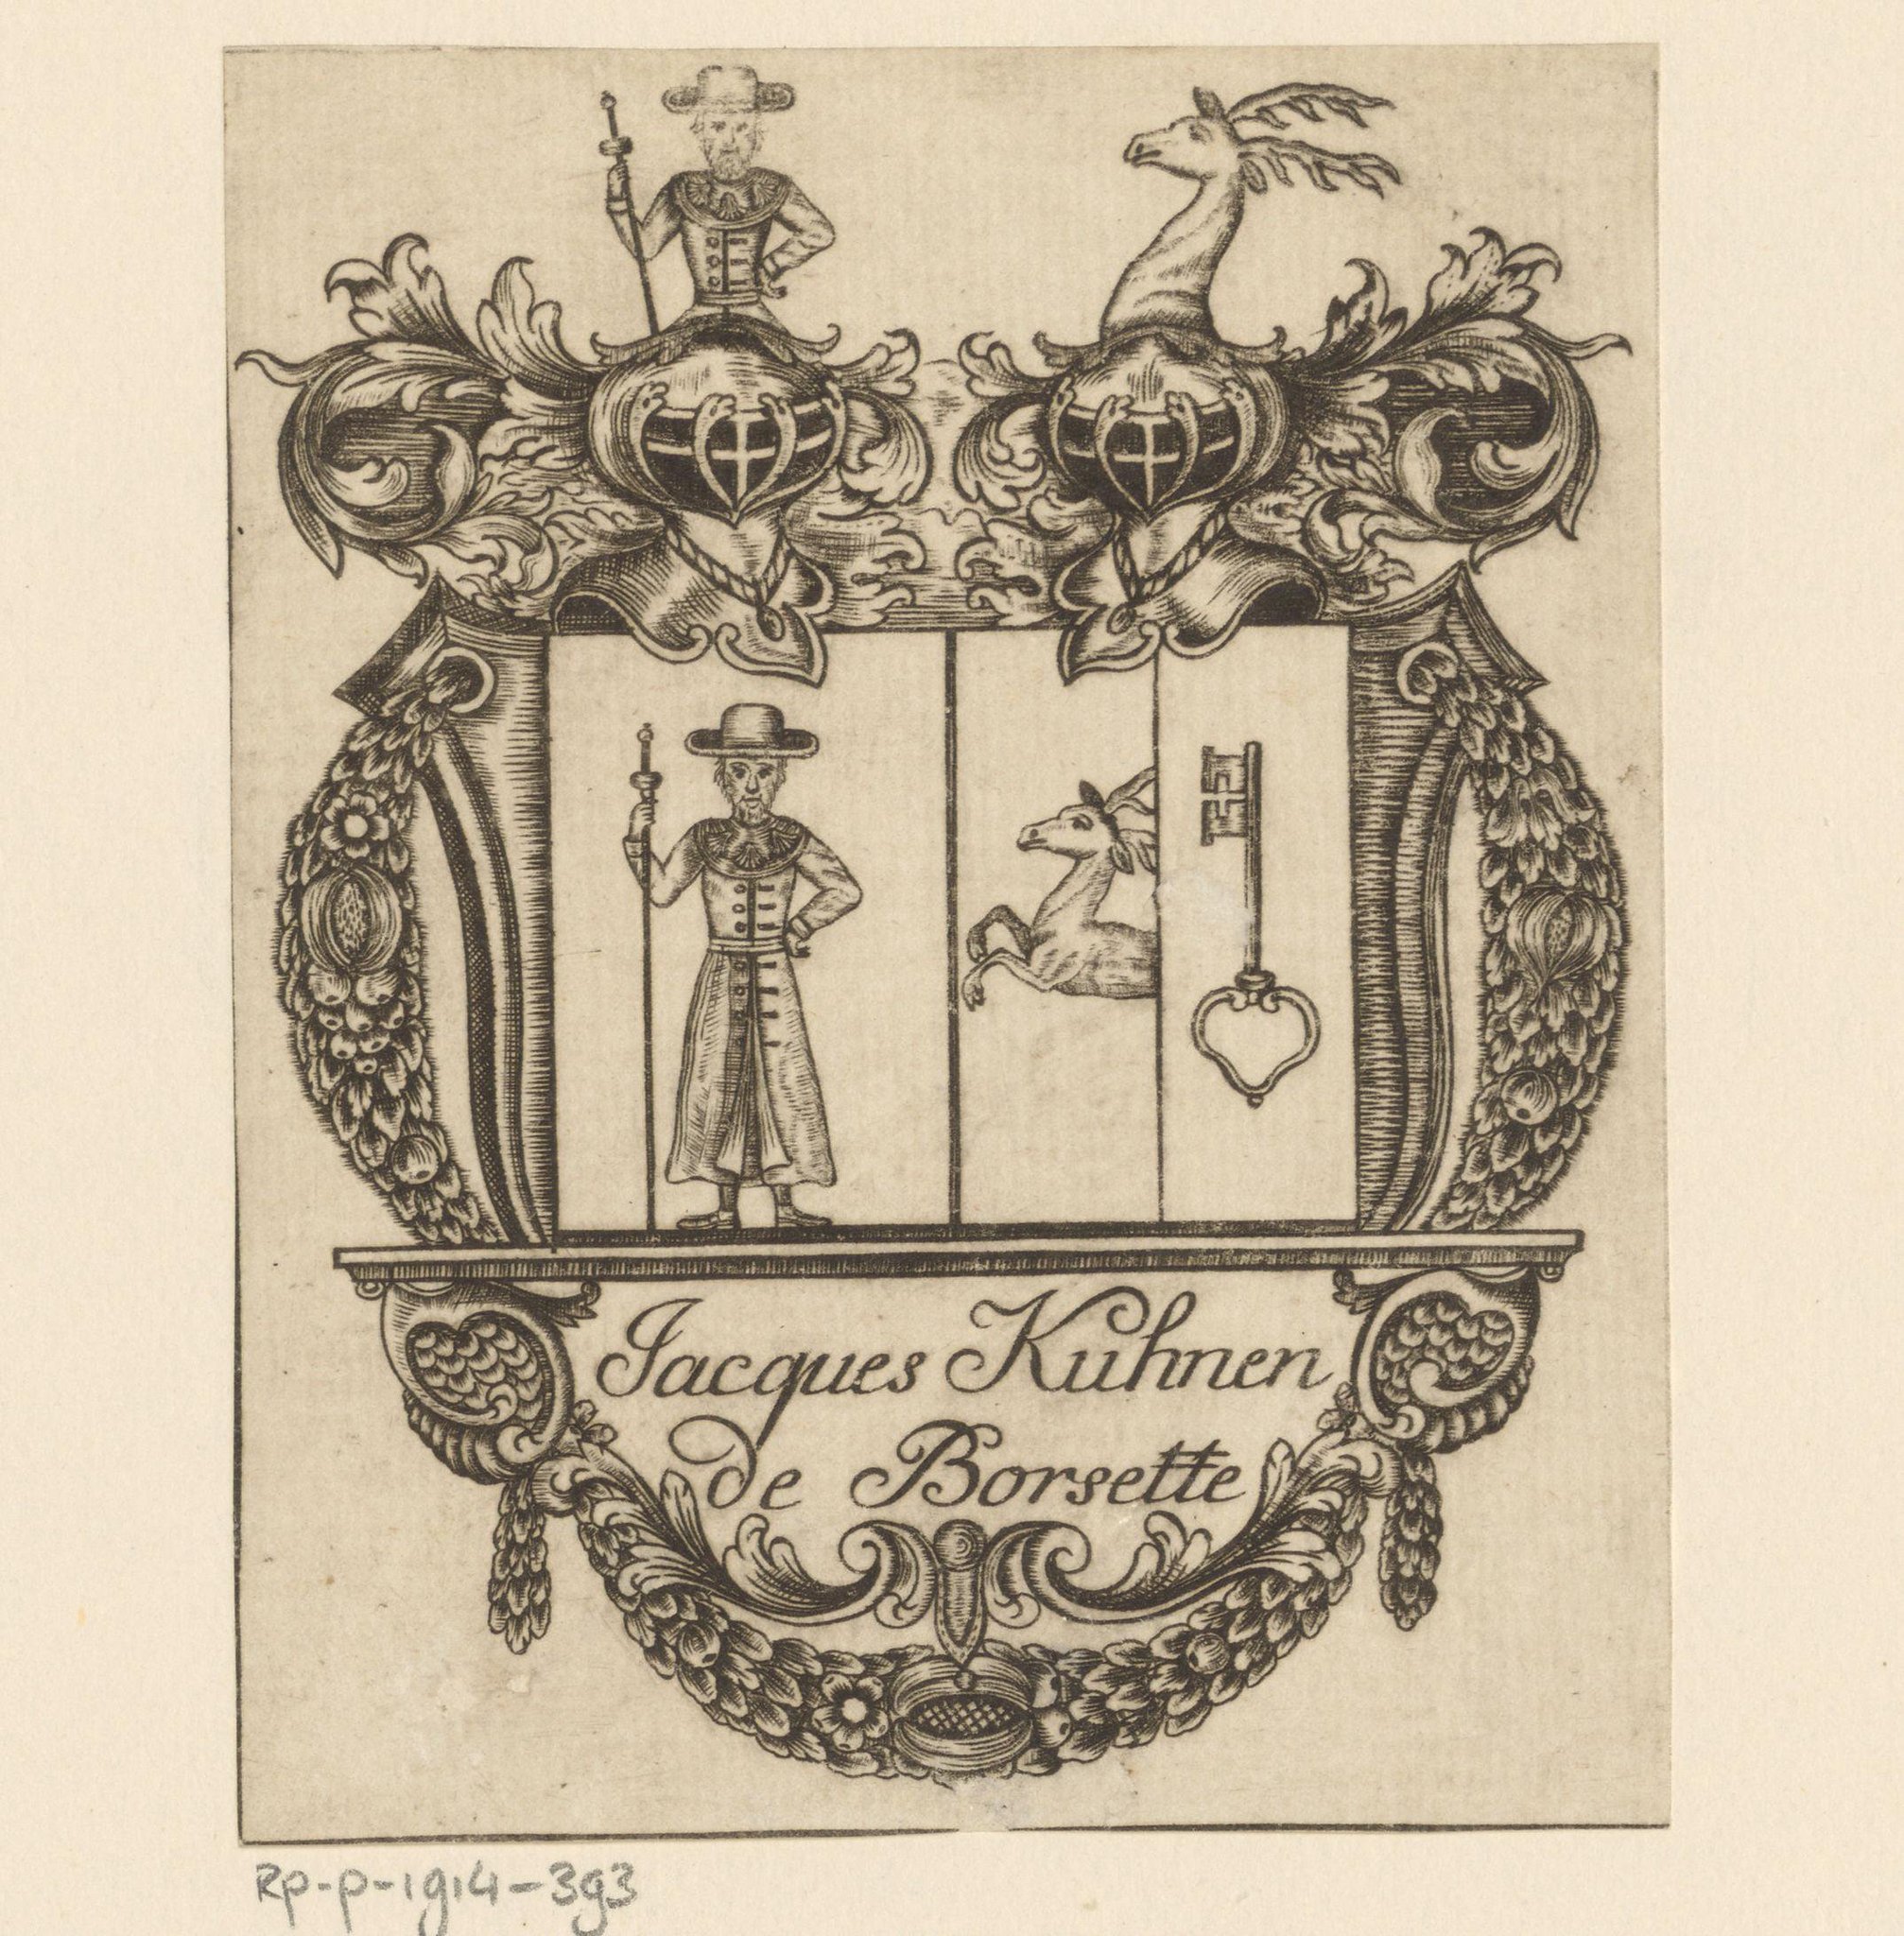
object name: bookplate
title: Ex libris van Jacques Kuhnen de Borsette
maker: Anonymous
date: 1600-1749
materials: paper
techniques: engraving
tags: armorial bearing, heraldry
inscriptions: collector's mark: Lugt 2760, collector's mark: Lugt 2233